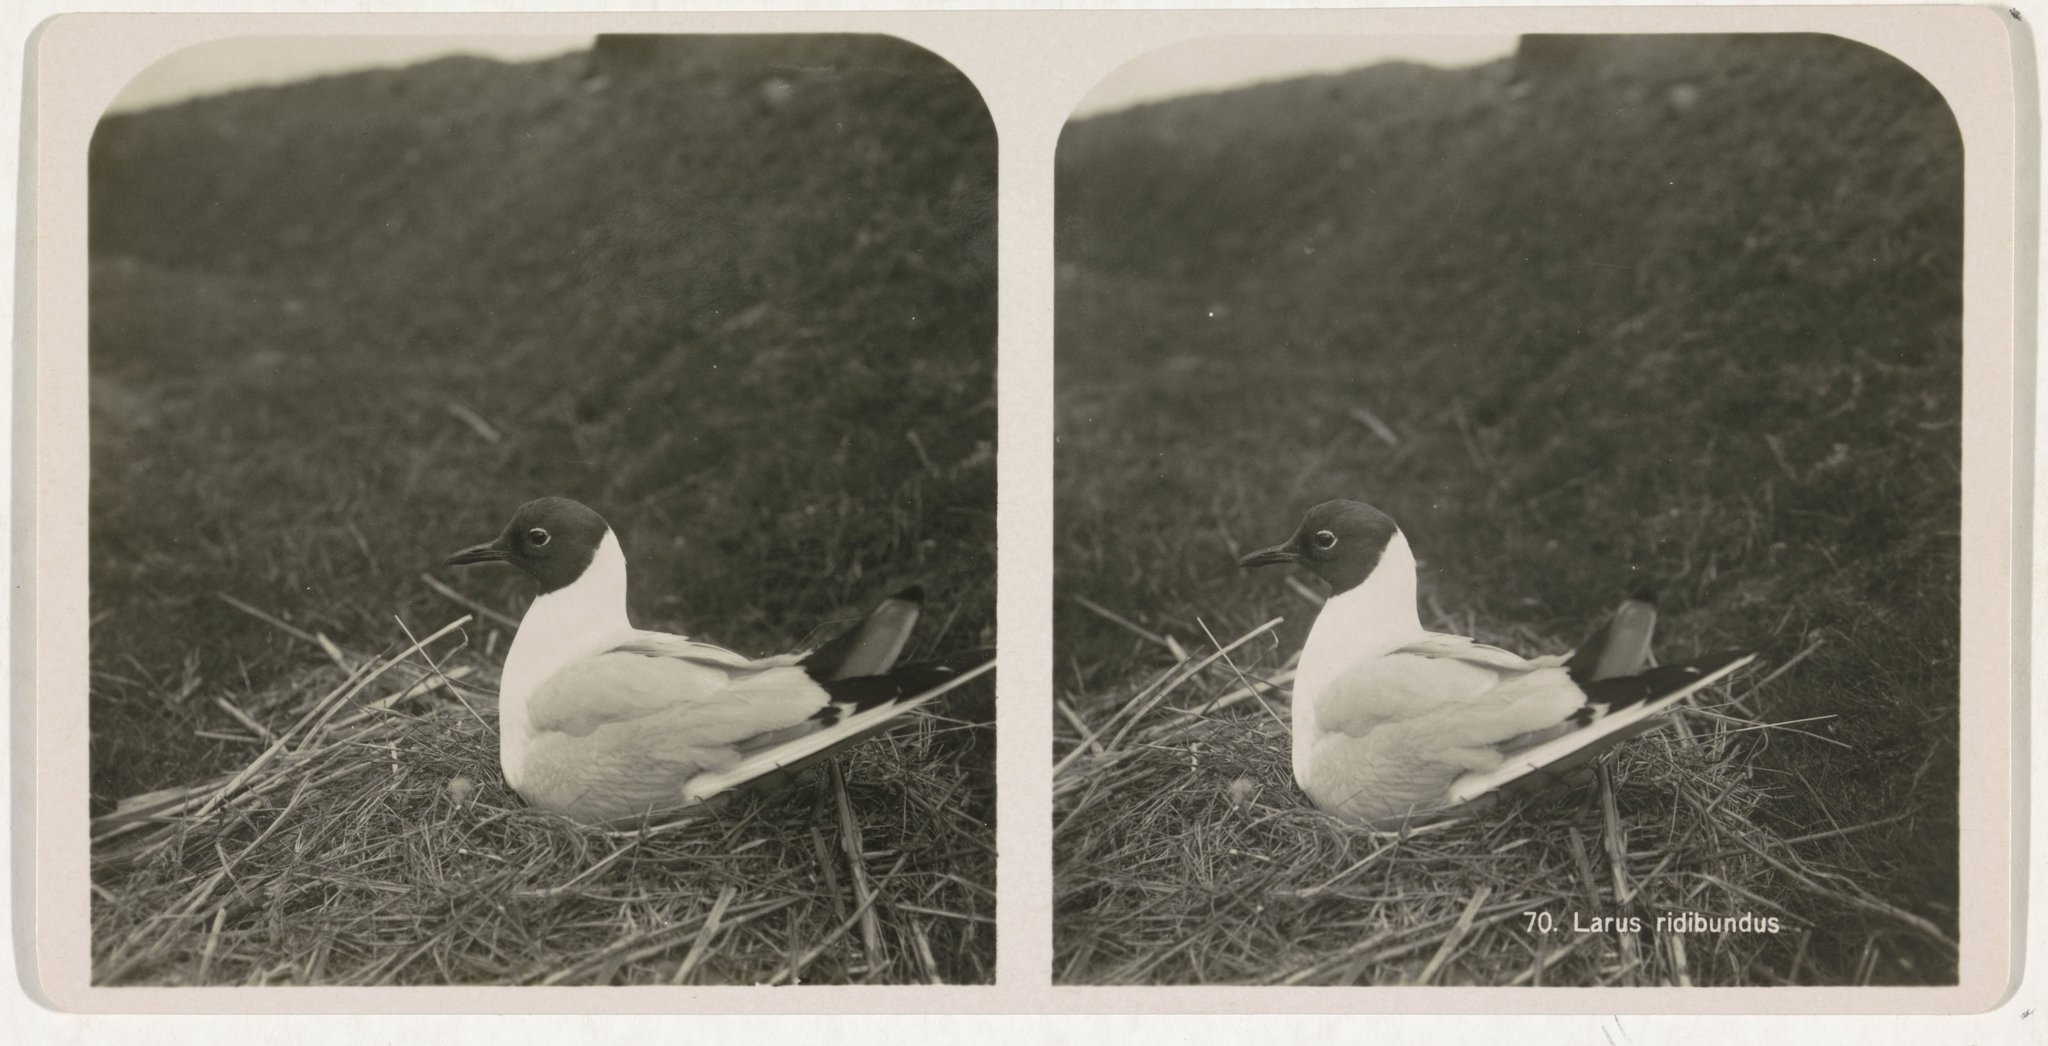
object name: photograph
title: Kokmeeuw broedend op nest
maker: adolphe burdet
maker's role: fotograaf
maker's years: 1860-1940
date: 1870-1940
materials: photographic support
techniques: gelatin silver print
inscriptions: label: ‘Meeuw’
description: De foto maakt deel uit van een serie van 12 stereofoto's, bewaard in het originele mapje. De foto's tonen zeevogels in natuurgebied De Bol op Texel.